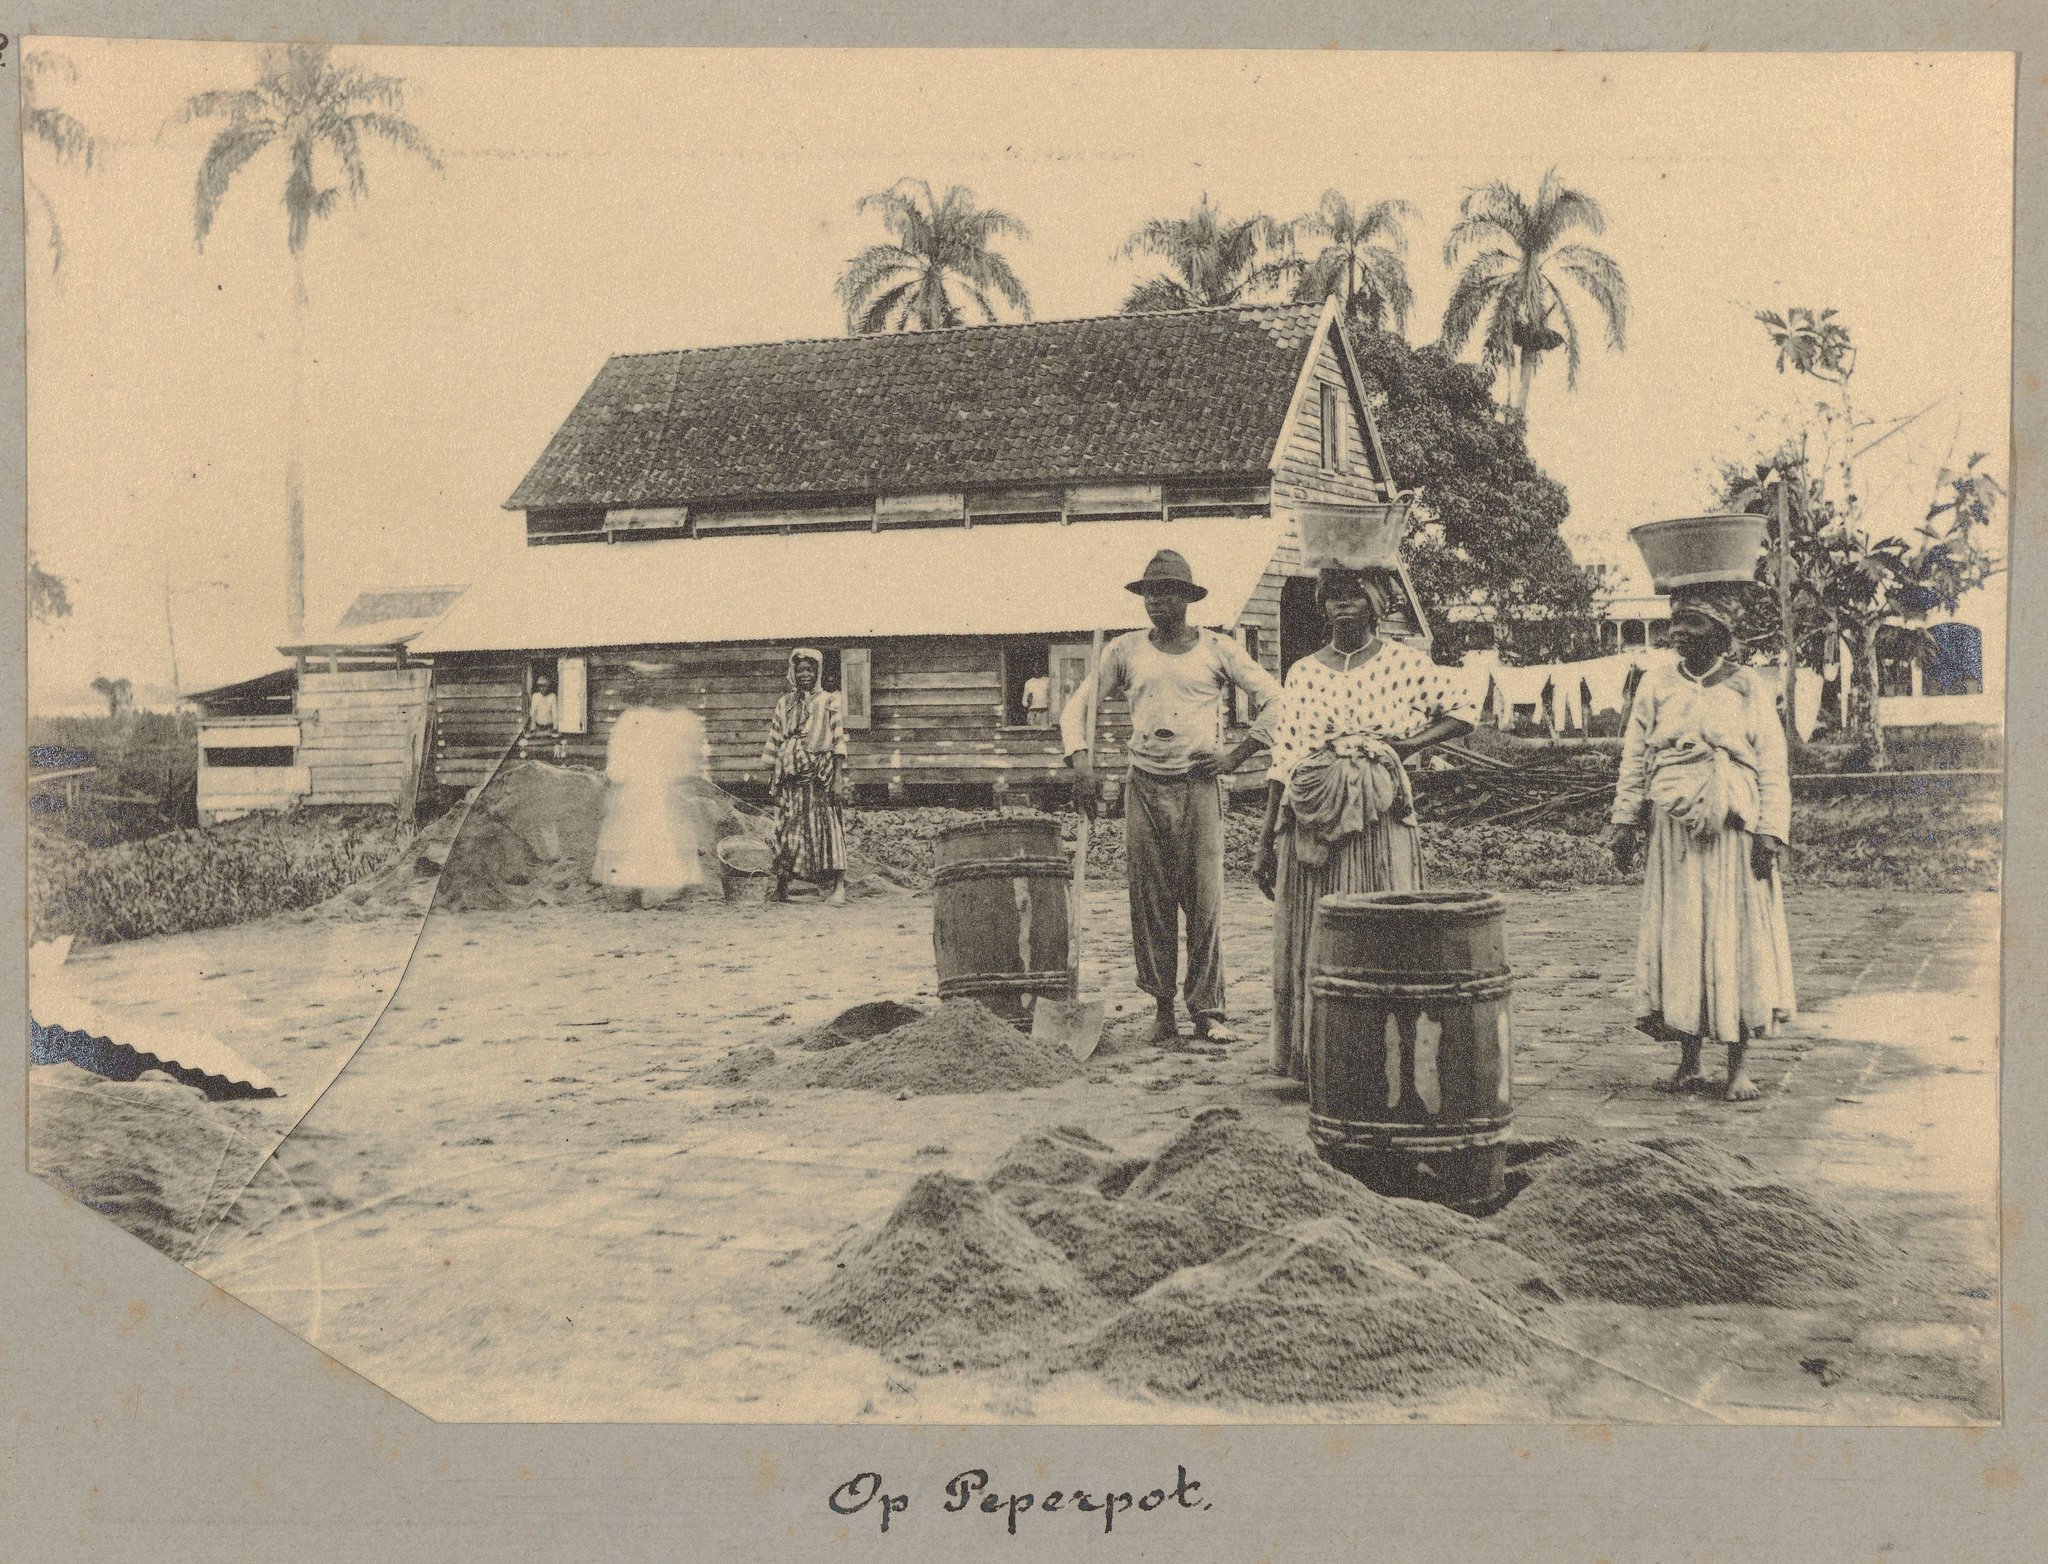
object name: photograph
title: Op Peperpot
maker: gomez burke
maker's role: fotograaf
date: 1891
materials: photographic support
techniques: gelatin silver print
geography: suriname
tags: suriname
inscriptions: inscription: ‘G.B. / Op Peterpot’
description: Arbeiders op de plantage Peperpot aan de Surinamerivier, op de grond staan enkele vaten tussen hopen van een gemalen goed, wellicht peper of koffie, mogelijk specie. Onderdeel van het fotoalbum Souvenir de Voyage (deel 4), over het leven van de familie Dooyer in en rond de plantage Ma Retraite in Suriname in de jaren 1906-1913.